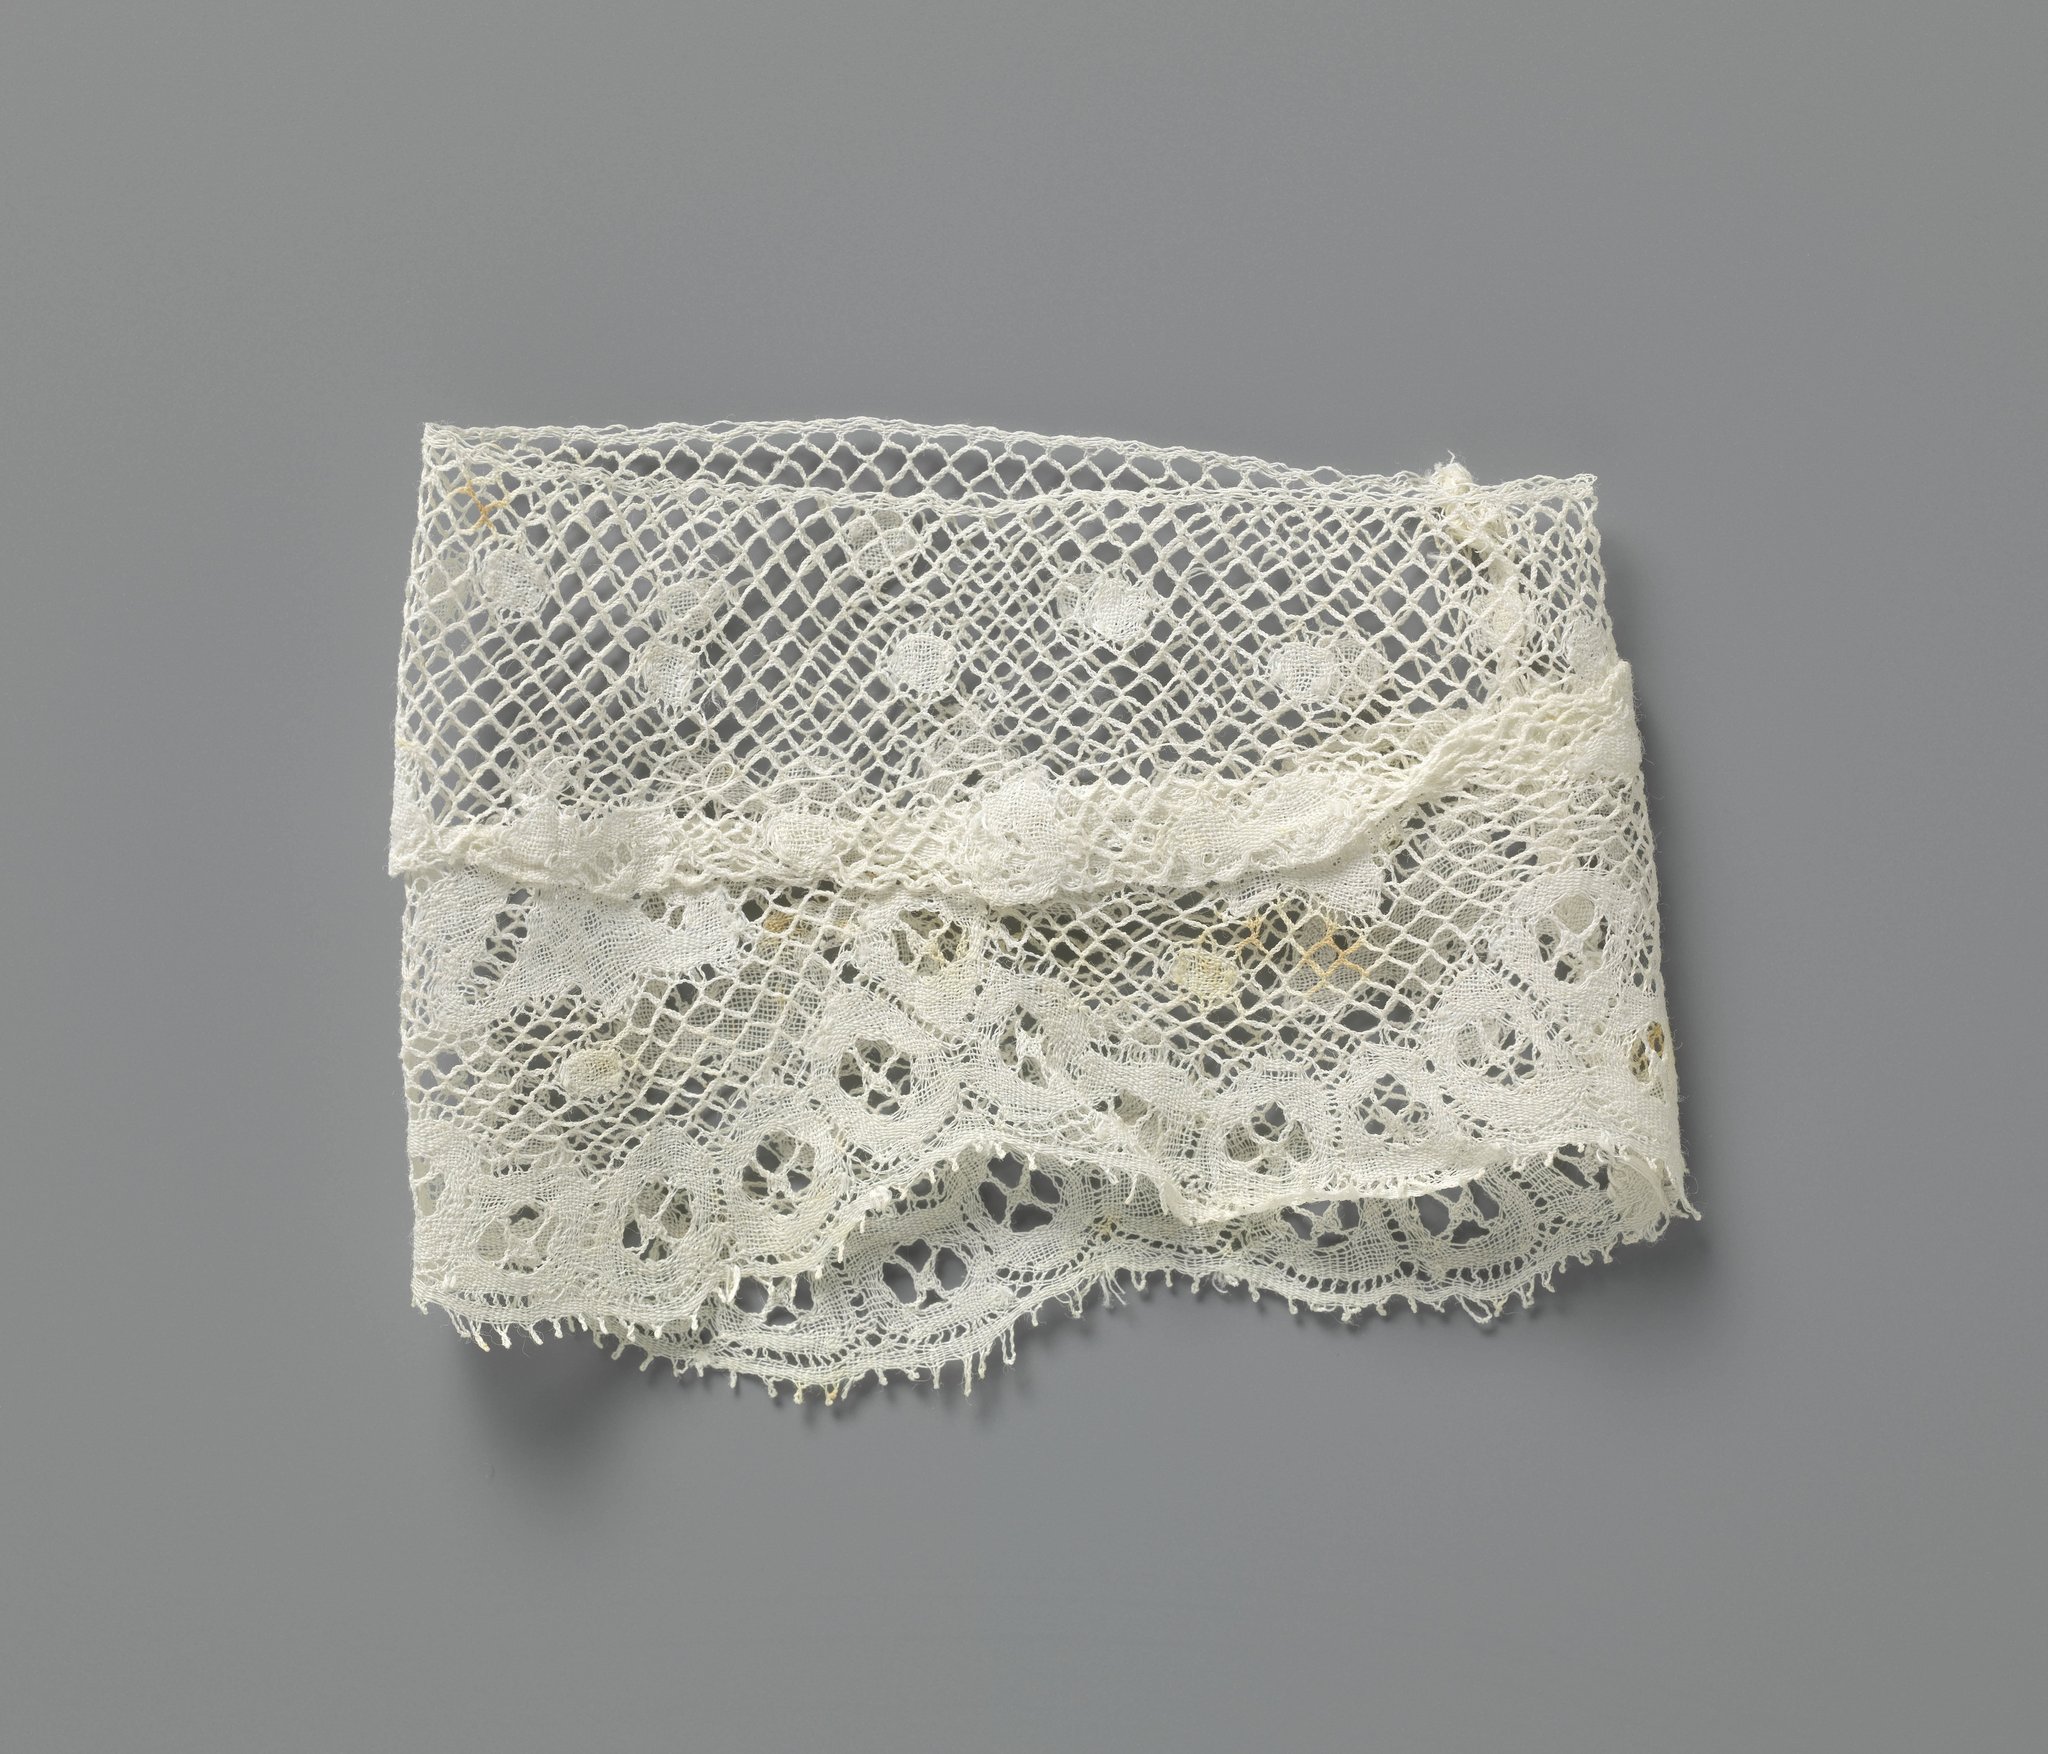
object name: cuff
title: Manchet van kloskant met klimopblad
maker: Anonymous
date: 1910-1920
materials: linen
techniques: lace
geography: netherlands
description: Manchet van naturelkleurig kloskant: Valenciennes-kant. Repetitief motief van klimopbladeren op een fijne vierkante Valenciennes-grond, met daarboven een rij met iets verspringende moesjes. De bovenzijde is afgewerkt met een rechte rand. Aan de onderzijde flauwe schulpen, die gevormd zijn door aaneengeschakelde radertjes. Rondom is de manchet ter hoogte van de rij bladeren een stukje dubbel gevouwen en vastgenaaid, waardoor het patroon deels wegvalt.